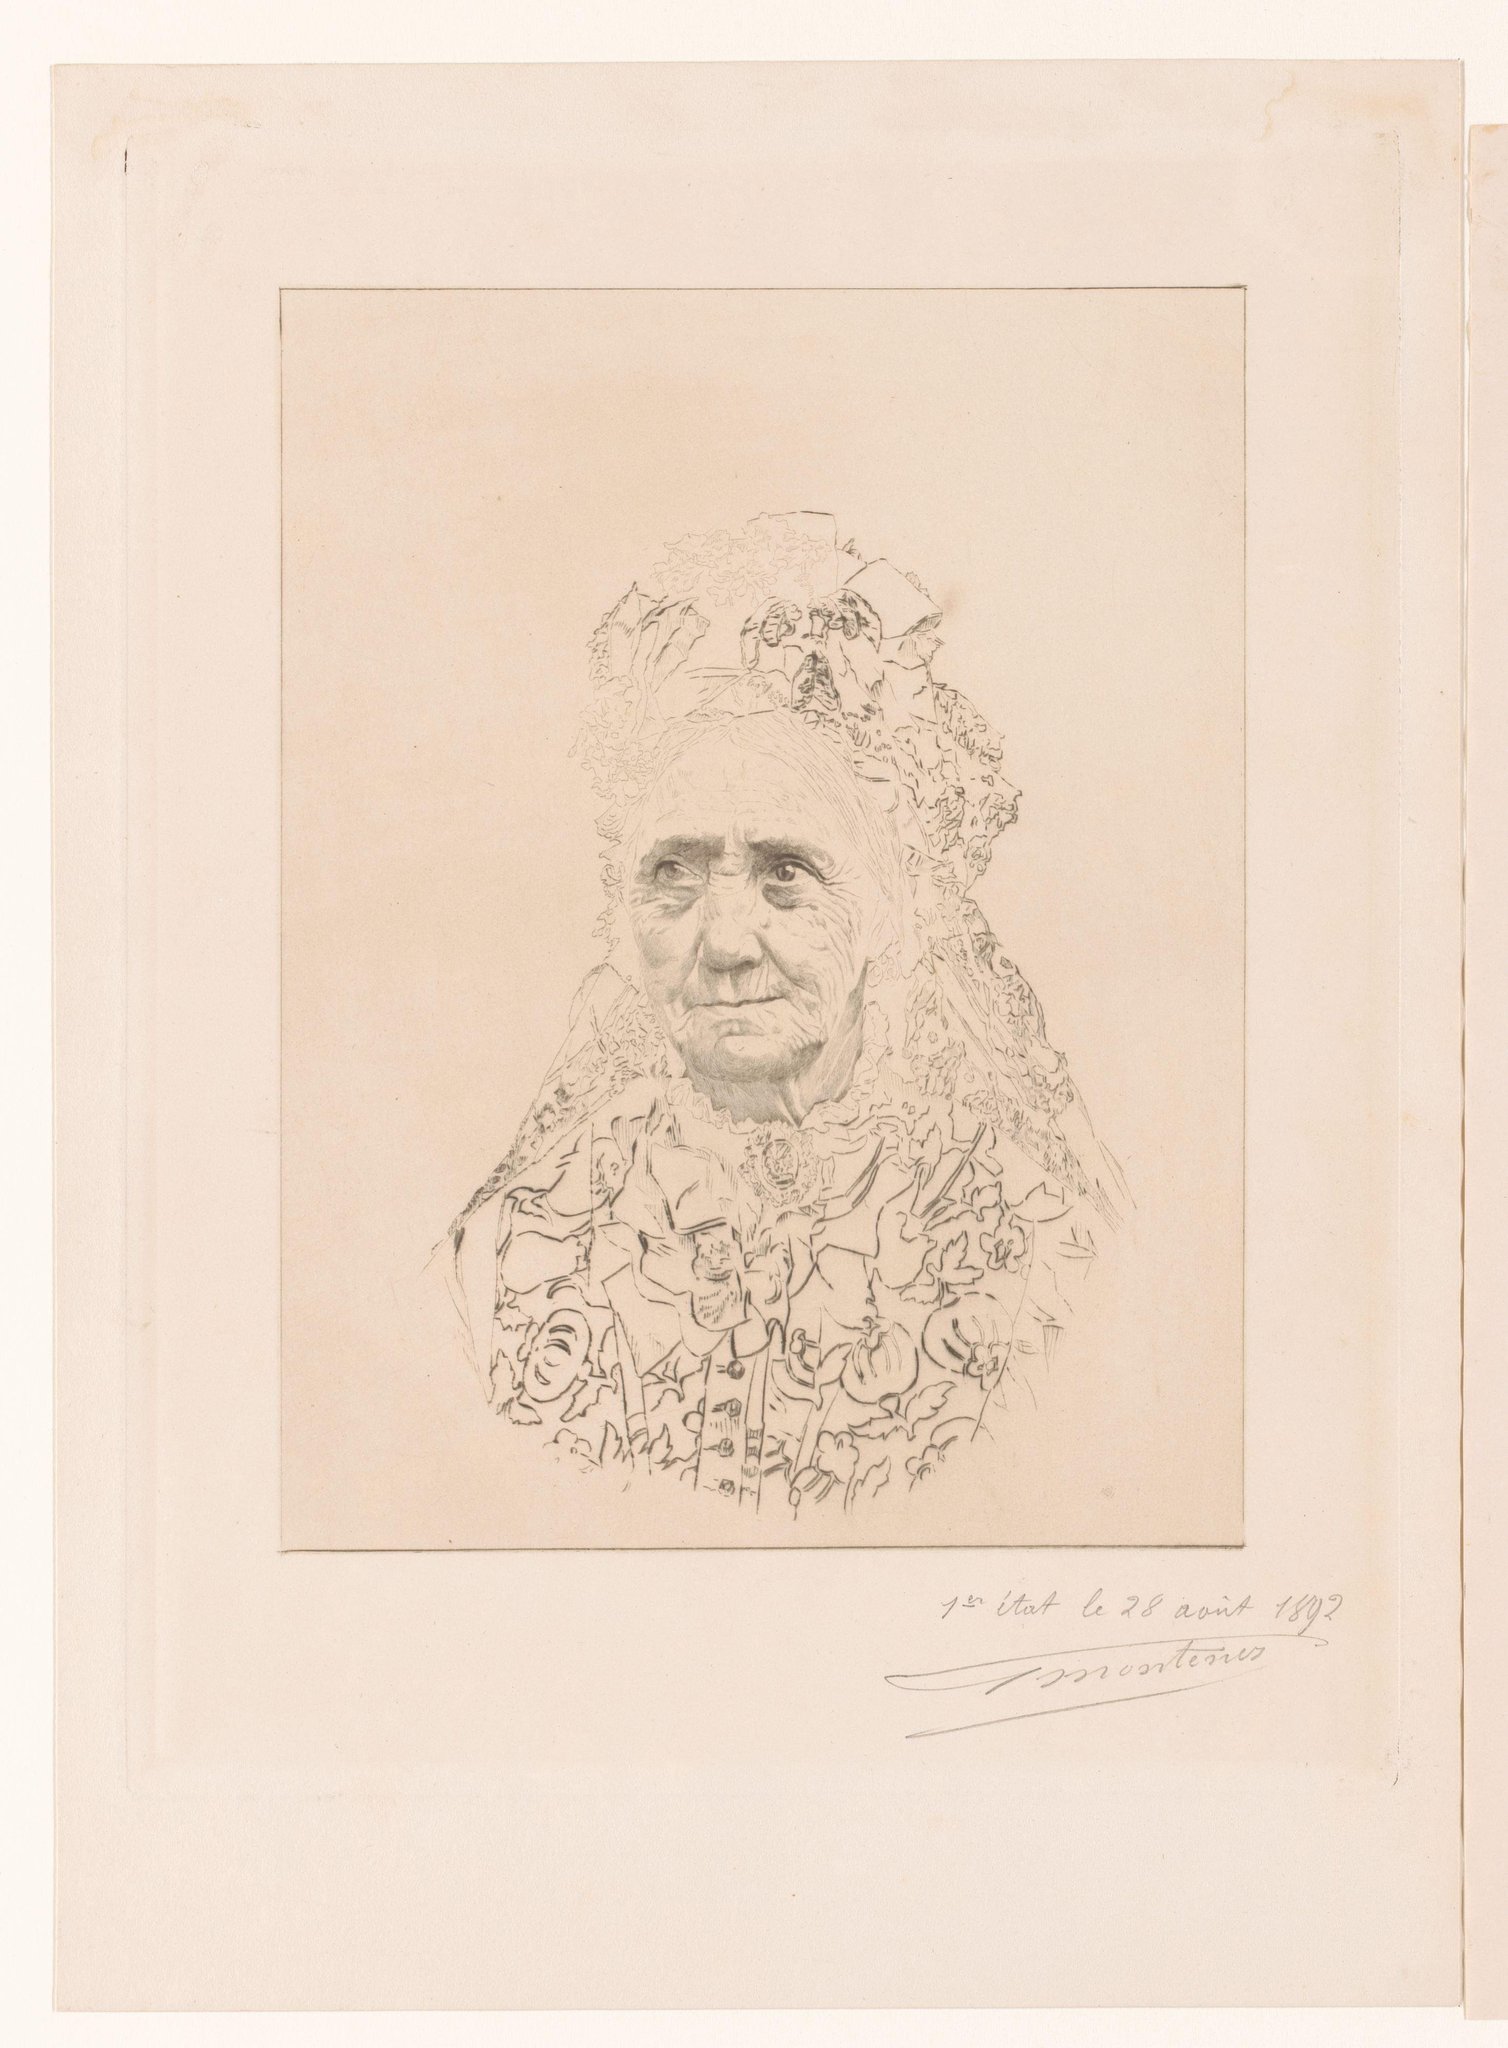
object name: print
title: Portret van een onbekende vrouw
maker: georges montenez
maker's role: print maker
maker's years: 1873-1930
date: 1892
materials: paper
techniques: etching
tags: head-gear, historical persons, old woman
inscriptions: inscription: ‘1er état le 28 août 1892’, collector's mark: Lugt 2228